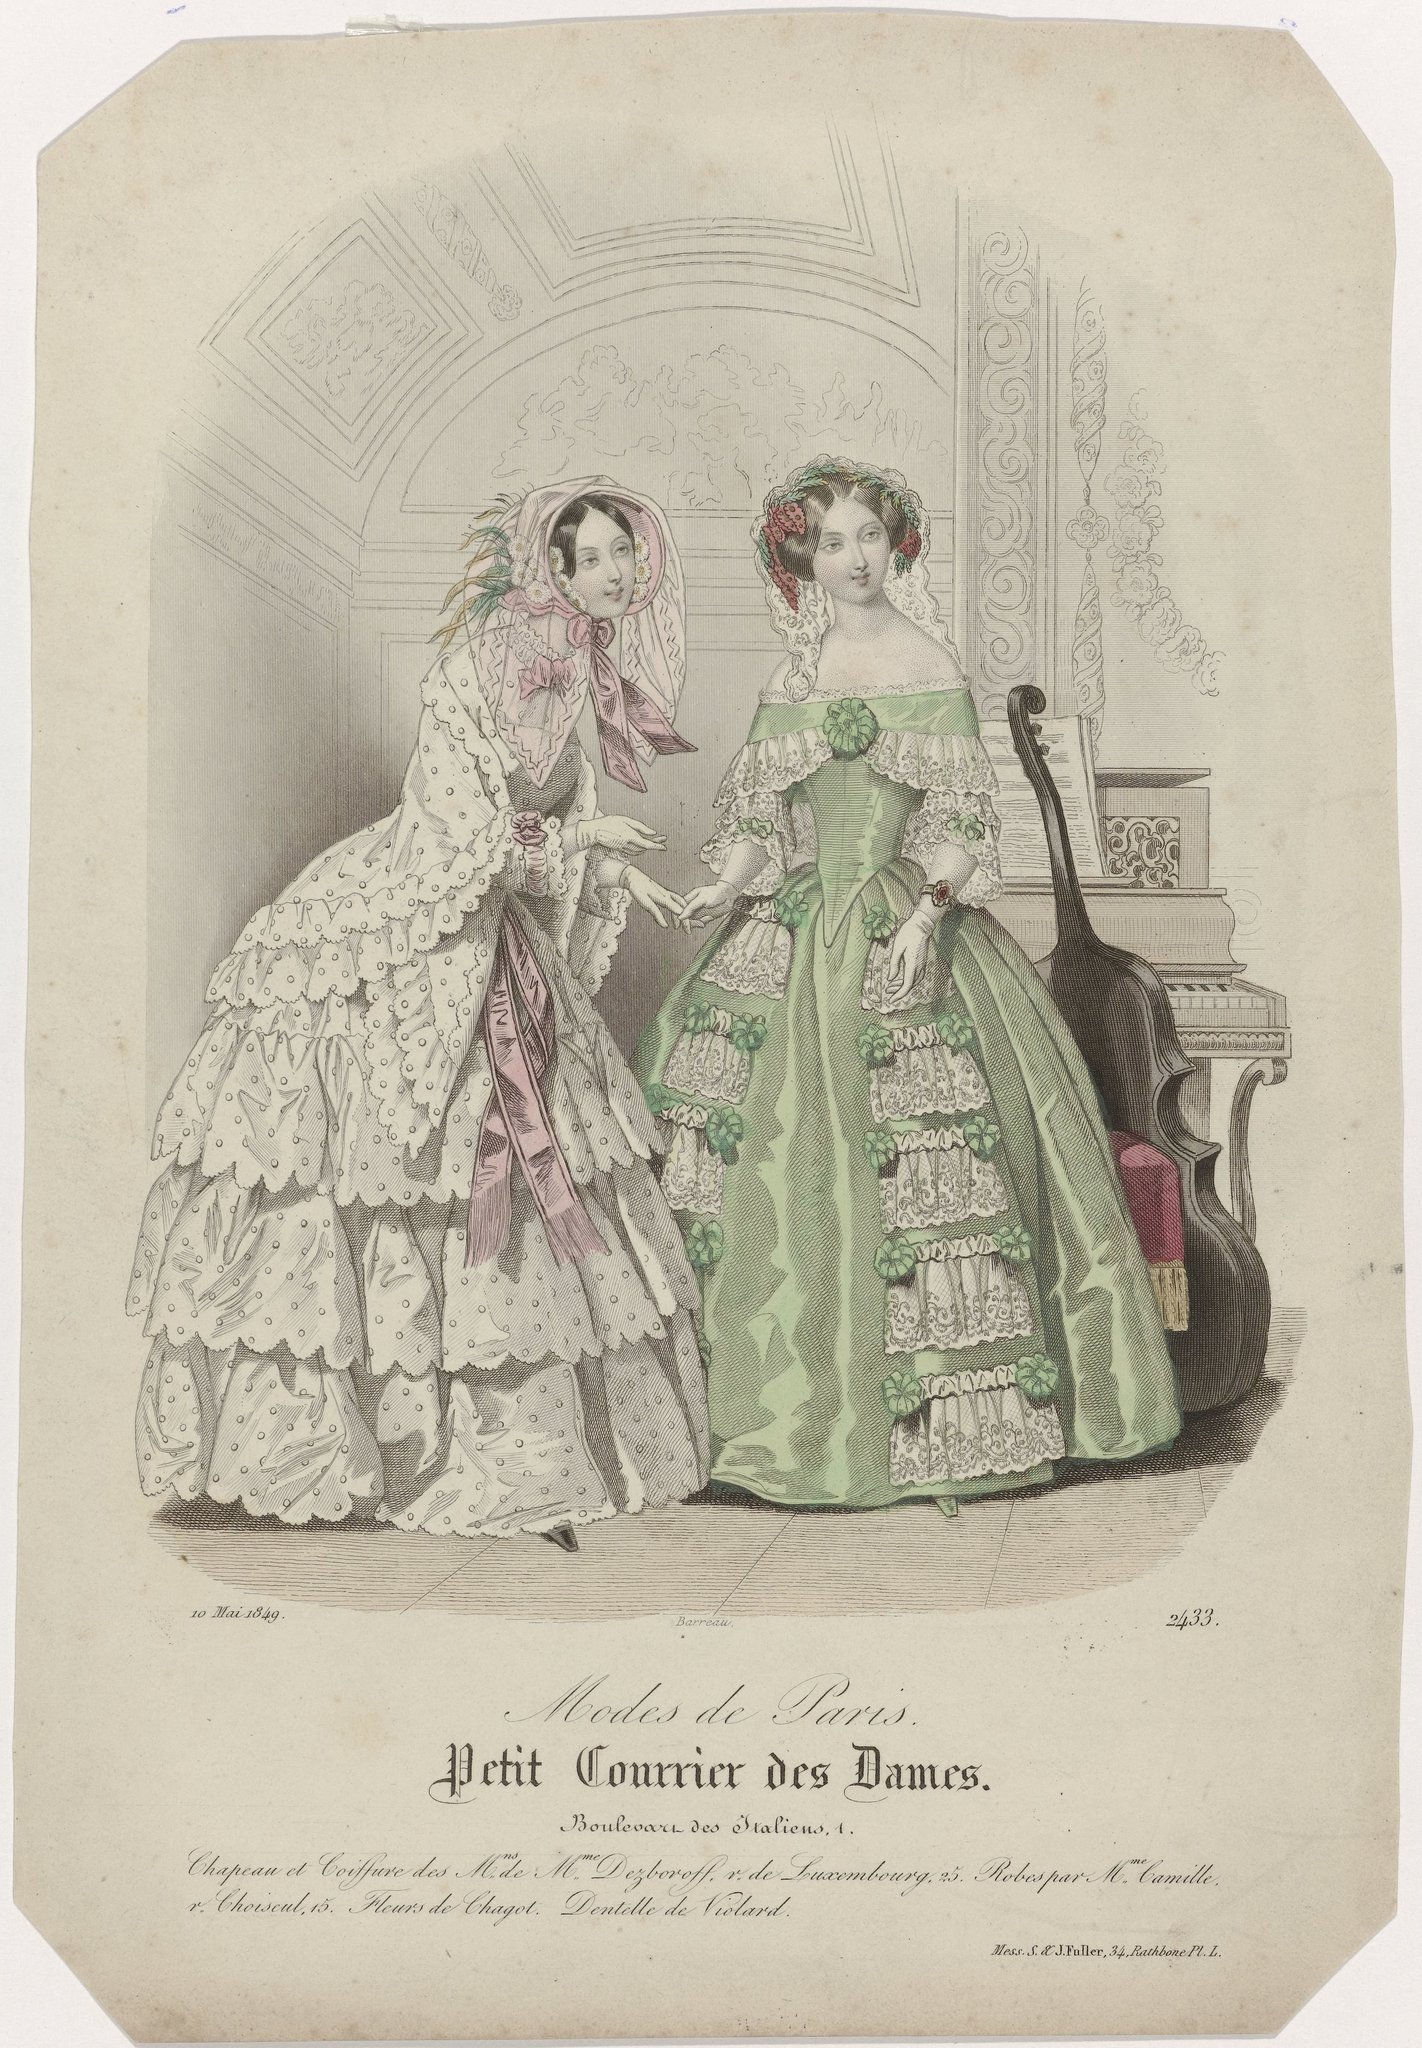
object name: fashion print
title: Petit Courrier des Dames, 10 mai 1849, No. 2433 : Chapeau et Coiffur (...)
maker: jean-charles-michel barreau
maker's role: print maker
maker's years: 1789-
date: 1849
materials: paper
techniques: engraving, hand coloring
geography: london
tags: flowers, clothing for the upper part of the body (+ women's clothes), lace (+ women's clothes), styles of hairdress - aa - ~ women, fashion plates, head-gear: hat (+ women's clothes), shoes, sandals (+ women's clothes), gloves, mittens, etc. (+ women's clothes), dress, gown (+ women's clothes), viola, violoncello; double bass, neck-gear ~ clothing (+ women's clothes), bracelet, wristlet (+ women's clothes), pianoforte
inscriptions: title: ‘Modes de Paris. / Petit Courrier des Dames.’, caption: ‘Chapeau et Coiffure des M"ns de M"me Desboroff, r. de Luxembourg, 25. Robes par M"me Camille. r"Choiseul, 15. Fleurs de Chagot. Dentelle de Violard.’, address: ‘Boulevart des Italiens, 1. / Mess. S. & J. Fuller, 34 Rathbone Pl. L.’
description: Twee vrouwen in een interieur, staande voor een contrabas en piano met bladmuziek. Volgens het onderschrift: hoed en 'coiffure' van de winkels van Desboroff. Japonnen door Camille. Hieronder enkele regels reclametekst voor verschillende producten. Prent uit het modetijdschrift Petit Courrier des Dames (1821-1868).